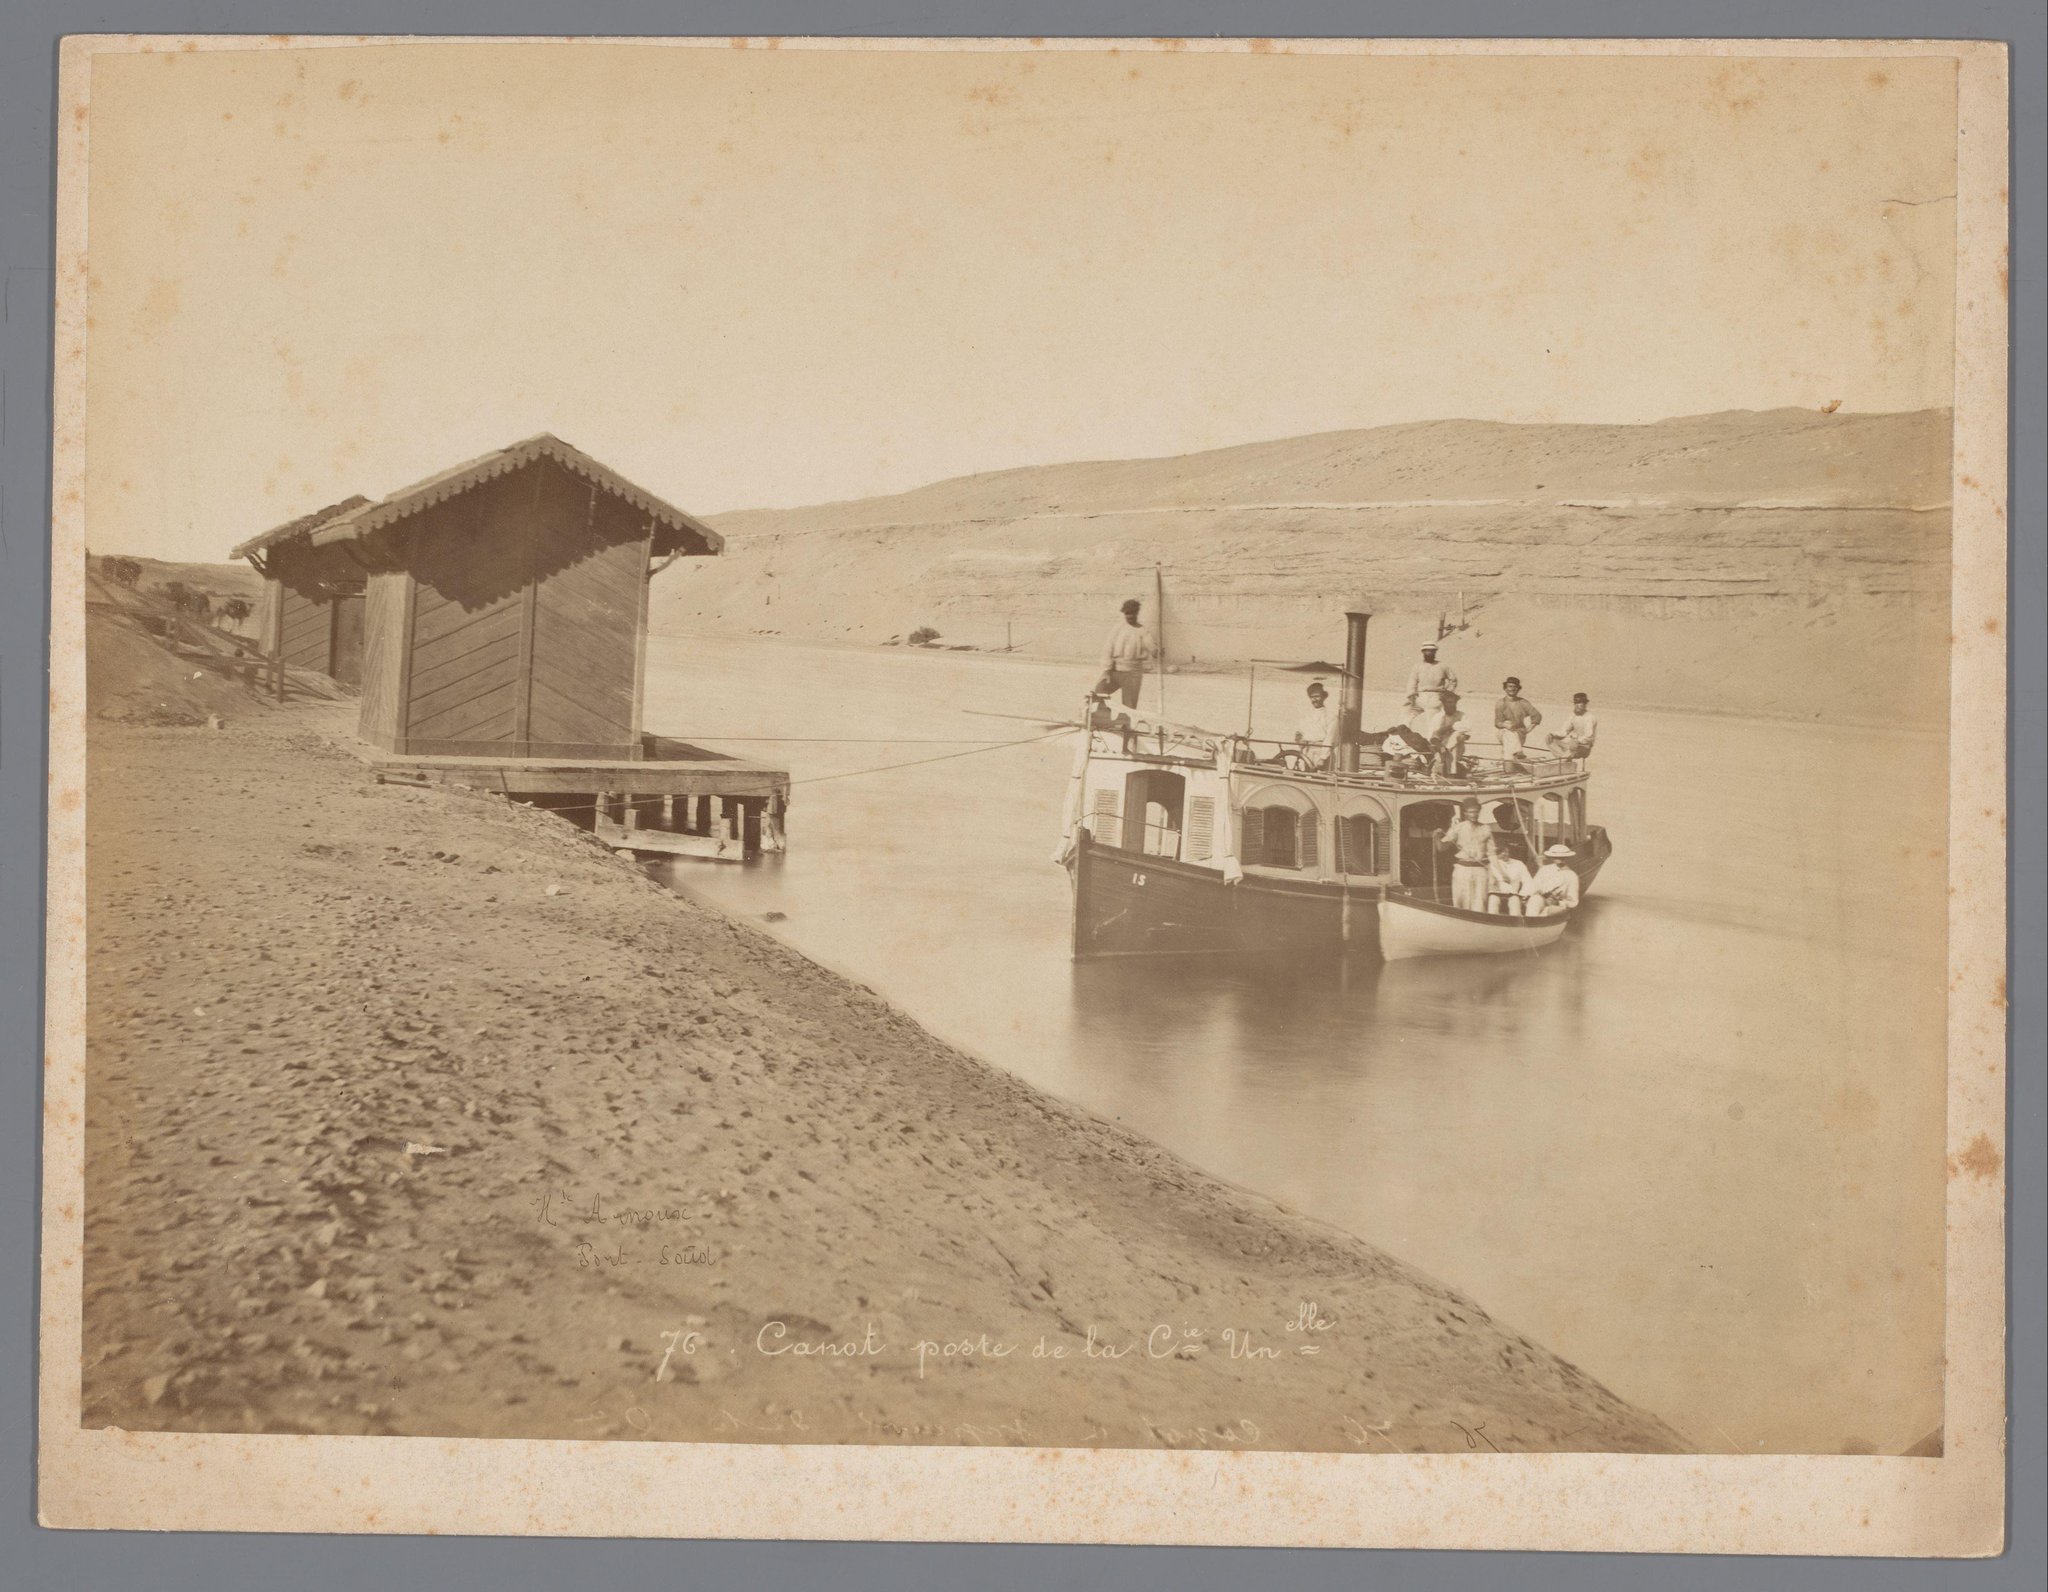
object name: photograph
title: Canot poste de la Cie Universelle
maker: hippolyte arnoux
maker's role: publisher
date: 1863-1890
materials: cardboard, paper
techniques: albumen print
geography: port said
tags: steamship, motorship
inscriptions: address: ‘FREDERIK MULLER & Co./ DOELENSTRAAT 16-18/ AMSTERDAM’, number: ‘76.’, inscription: ‘Archief F. Muller & Co.’